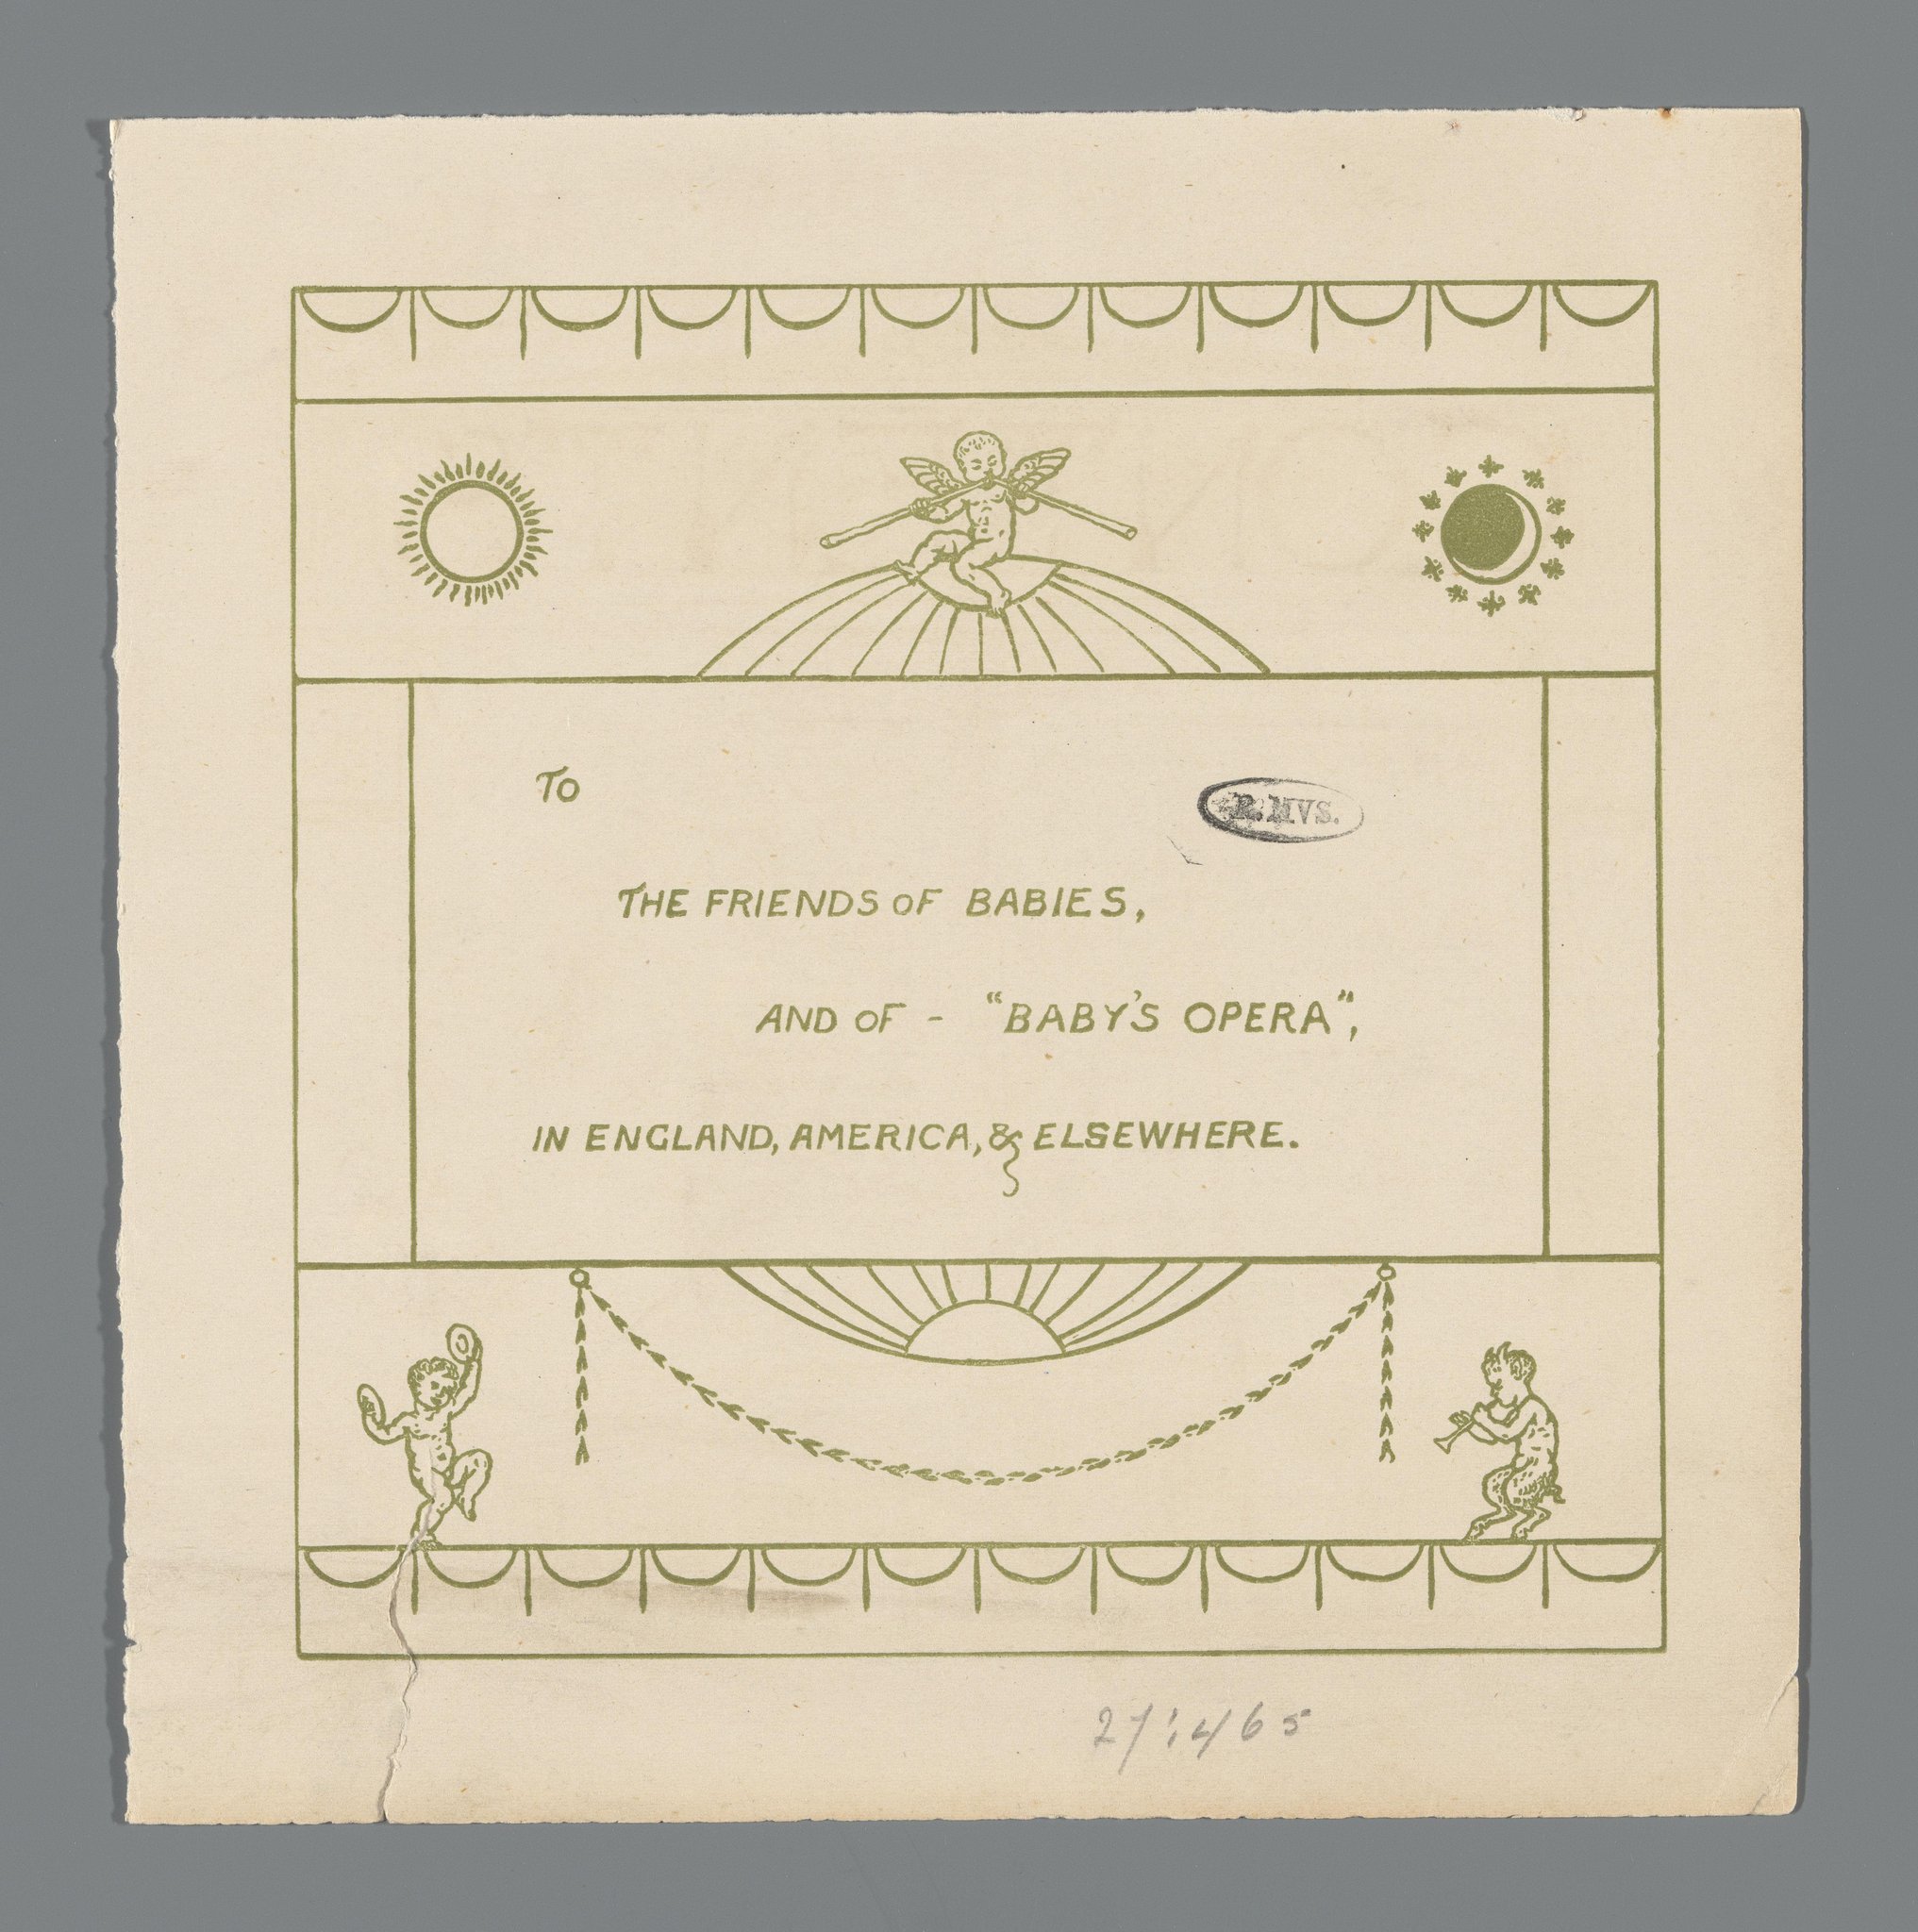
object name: book illustration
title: To the friends of babies, and of - 'Baby's opera'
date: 1878-1927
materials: paper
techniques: wood engraving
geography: london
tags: sun as celestial body, cupids: 'amores', 'amoretti', 'putti', moon as celestial body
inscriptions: collector's mark: Lugt 2228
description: Prent uit: The baby's bouquet, a fresh bunch of old rhymes and tunes. Londen: Routledge & Sons, [1878]. Of een latere uitgave.